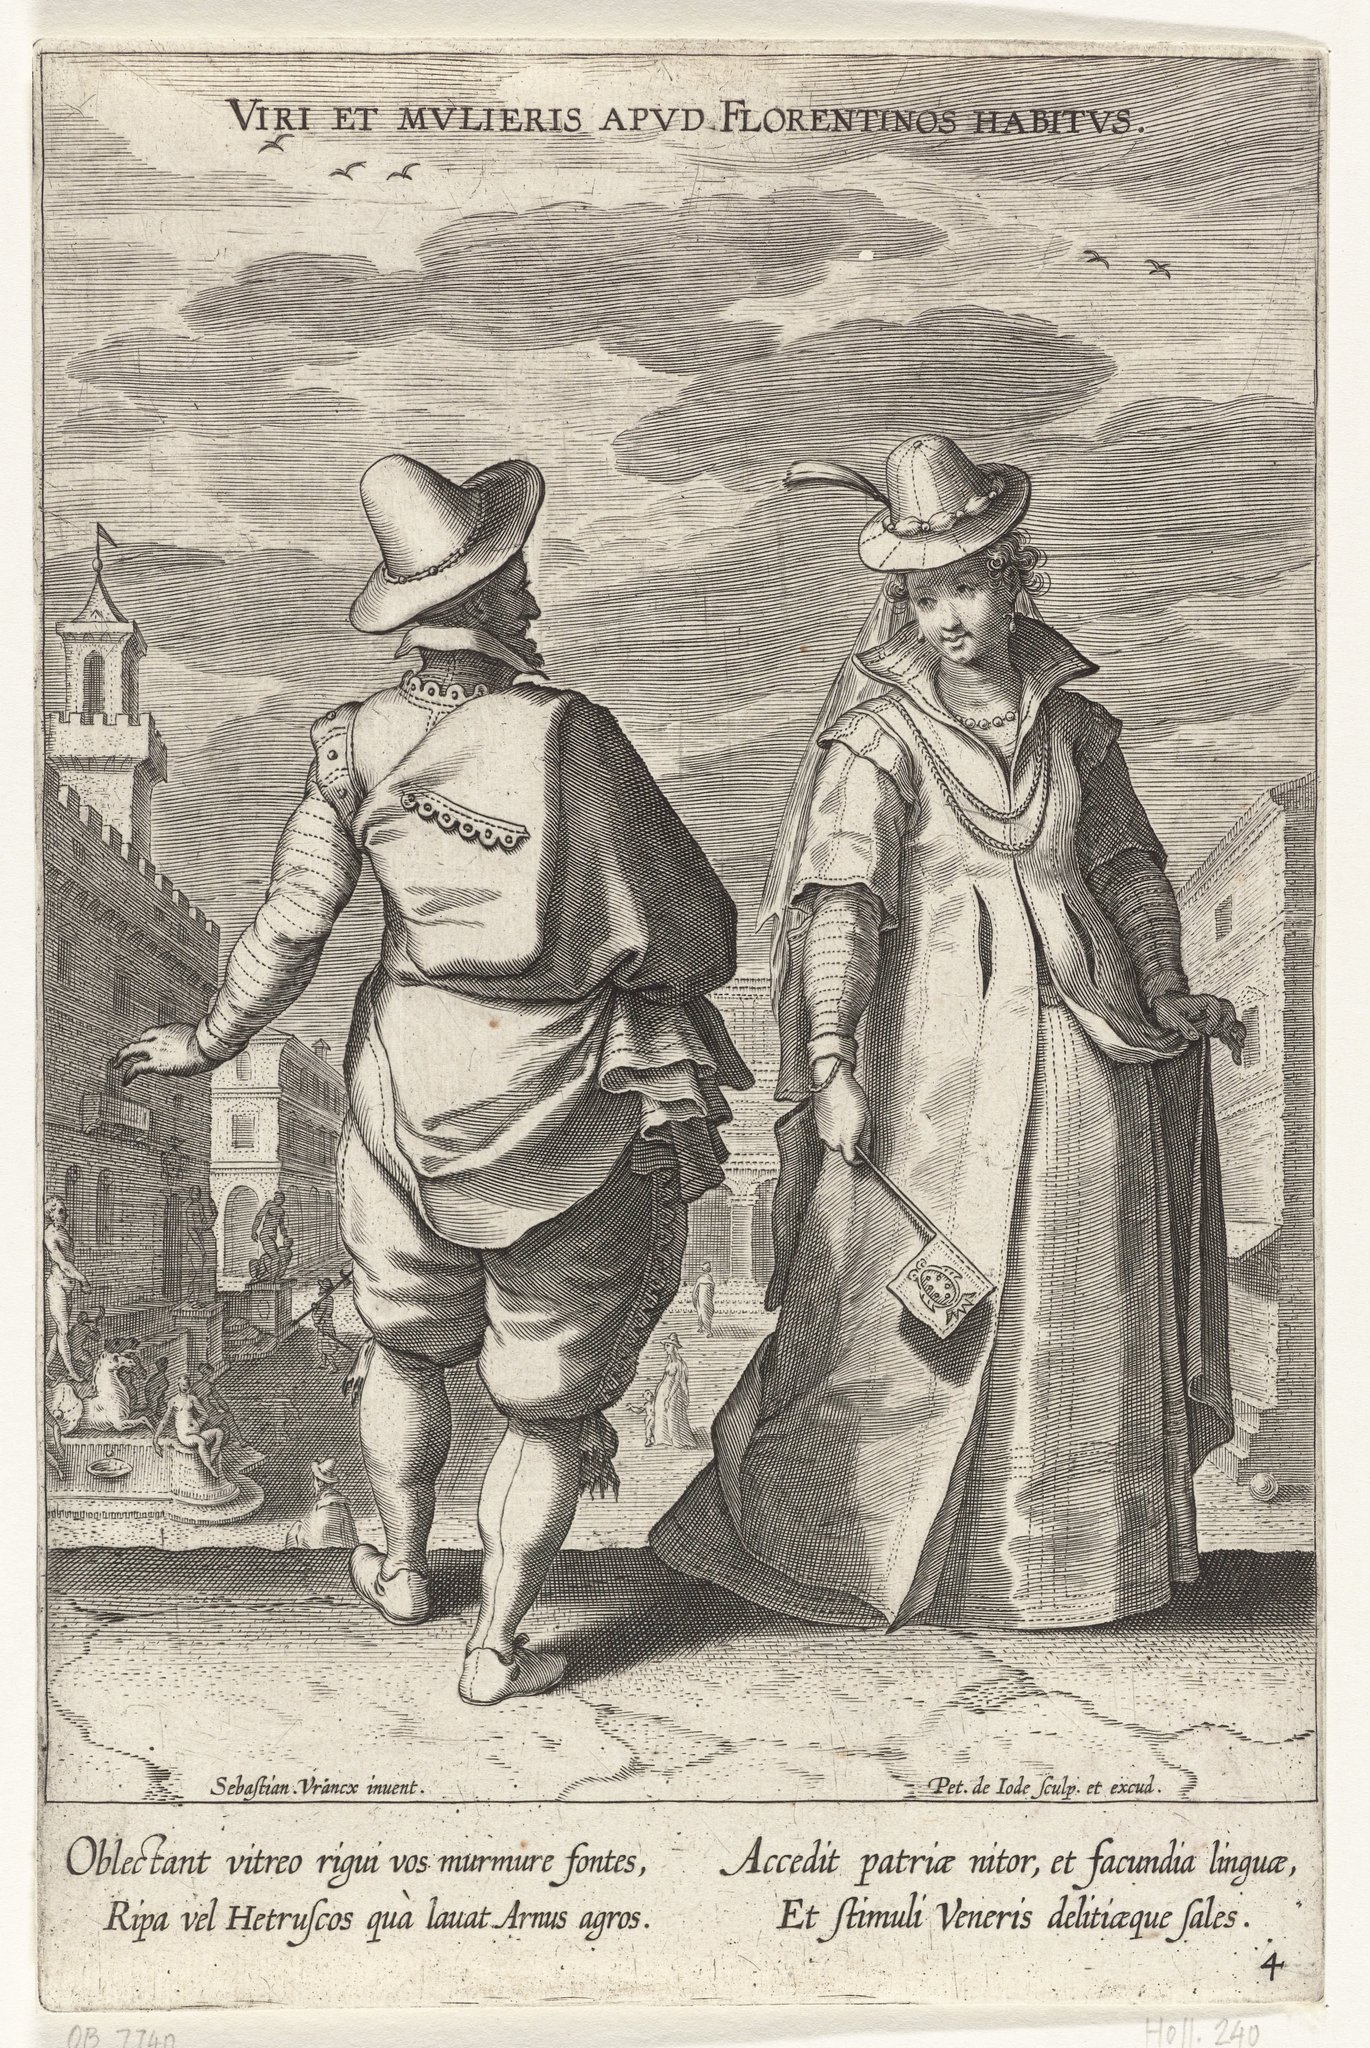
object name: costume print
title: Kostuums uit verschillende landen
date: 1605-1610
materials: paper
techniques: engraving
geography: antwerp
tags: veil (+ women's clothes), sleeves, coat (+ men's clothes), dress, gown (vlieger) (+ women's clothes), head-gear: hat (+ men's clothes), neck-gear: collar (+ women's clothes), clothes, costume (+ women's clothes), head-gear: hat (+ women's clothes), shoes, sandals (+ women's clothes), clothes, costume (+ men's clothes), folk costume, regional costume, fan (+ women's clothes), trousers, breeches, etc. (breeches) (+ men's clothes), clothing for the upper part of the body (doublet) (+ men's clothes)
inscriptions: caption: ‘Oblectant vitreo rigui vos murmure fontes, / Ripa vel Hetruscos qua lauat Arnus agros./ Accedit patriae nitor, et facundia linguae, / Et stimuli Veneris delitiaeque sales.’, collector's mark: Lugt 240, title: ‘VIRI ATQUE MULIERIS APVD FLORENTINOS HABITVS.’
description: Man en vrouw gekleed volgens de mode van Florence, 1607-1610. Ze staan naast elkaar: de man op de rug gezien, de vrouw van voren gezien. De vrouw draagt een vliegerkostuum met opstaande kraag, schouderkleppen en open hangmouwen. Op haar hoofd een hoed met taps toelopende bol, veer en sluier. Ze houdt een vaantje in de rechterhand. De man is gekleed in wambuis met schouderkleppen, kniebroek en schoudermantel. Hij draagt kousen met naad en schoenen met striksluiting. Op zijn hoofd een hoed met taps toelopende bol. De achtergrond wordt gevormd door een plein in Florence. (Met 4 regels onderschrift. in Latijn.)